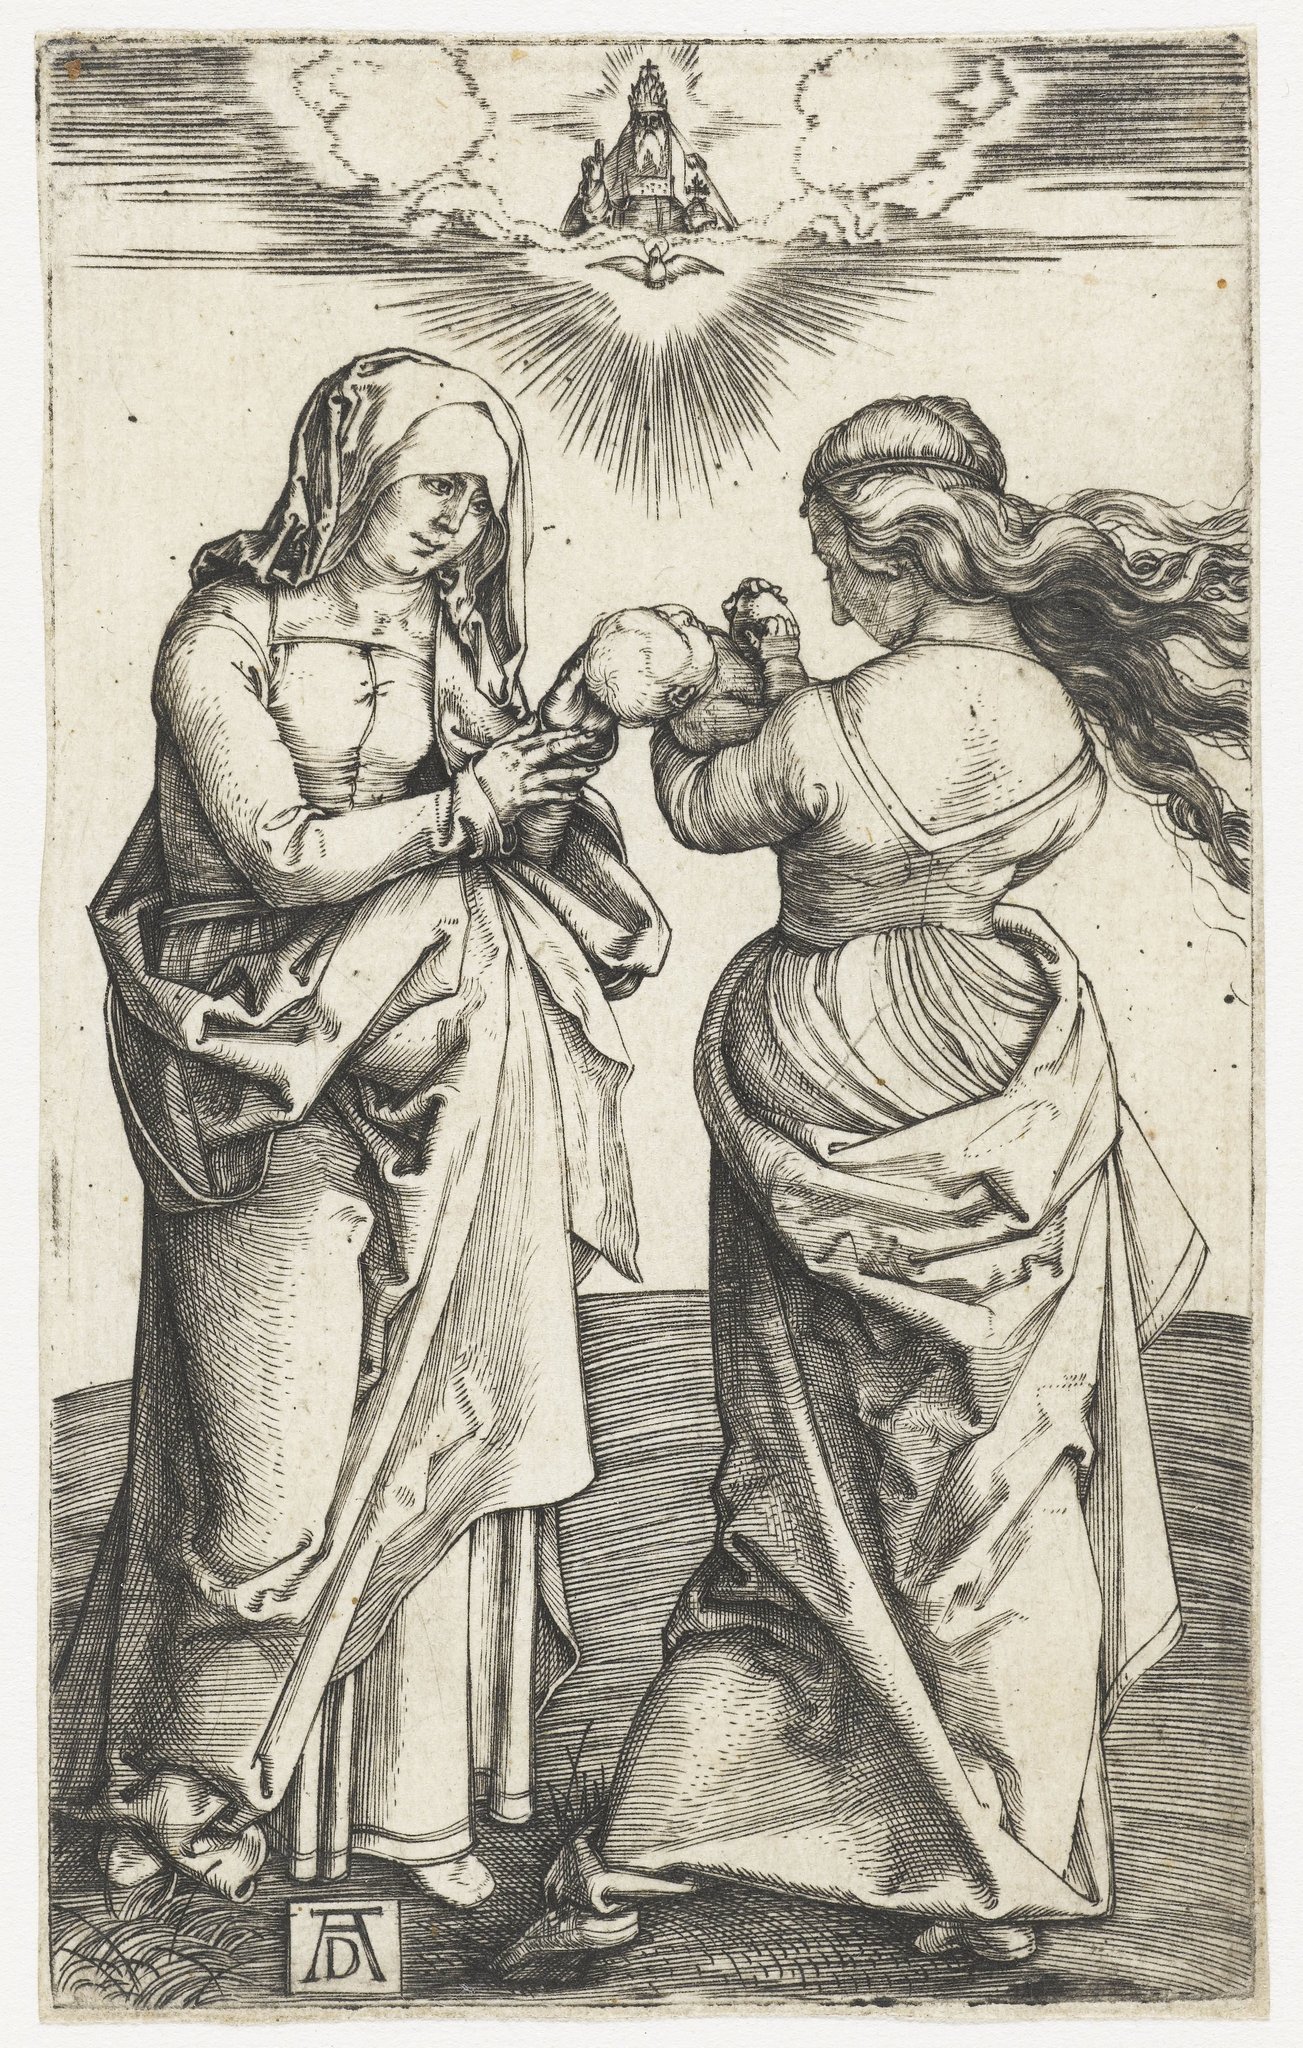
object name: print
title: Anna te Drieën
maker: albrecht dürer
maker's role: draughtsman, painter, print maker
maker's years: 1471-1528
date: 1498-1502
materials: paper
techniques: engraving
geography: nuremberg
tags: 'anna selbdritt', i.e. anna, mary and christ-child close together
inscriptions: collector's mark: Lugt 2228a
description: Maria, op de rug gezien, met het Christuskind in de armen, naast Anna. Boven hun hoofden God en de Heilige Geest in de gedaante van een duif.